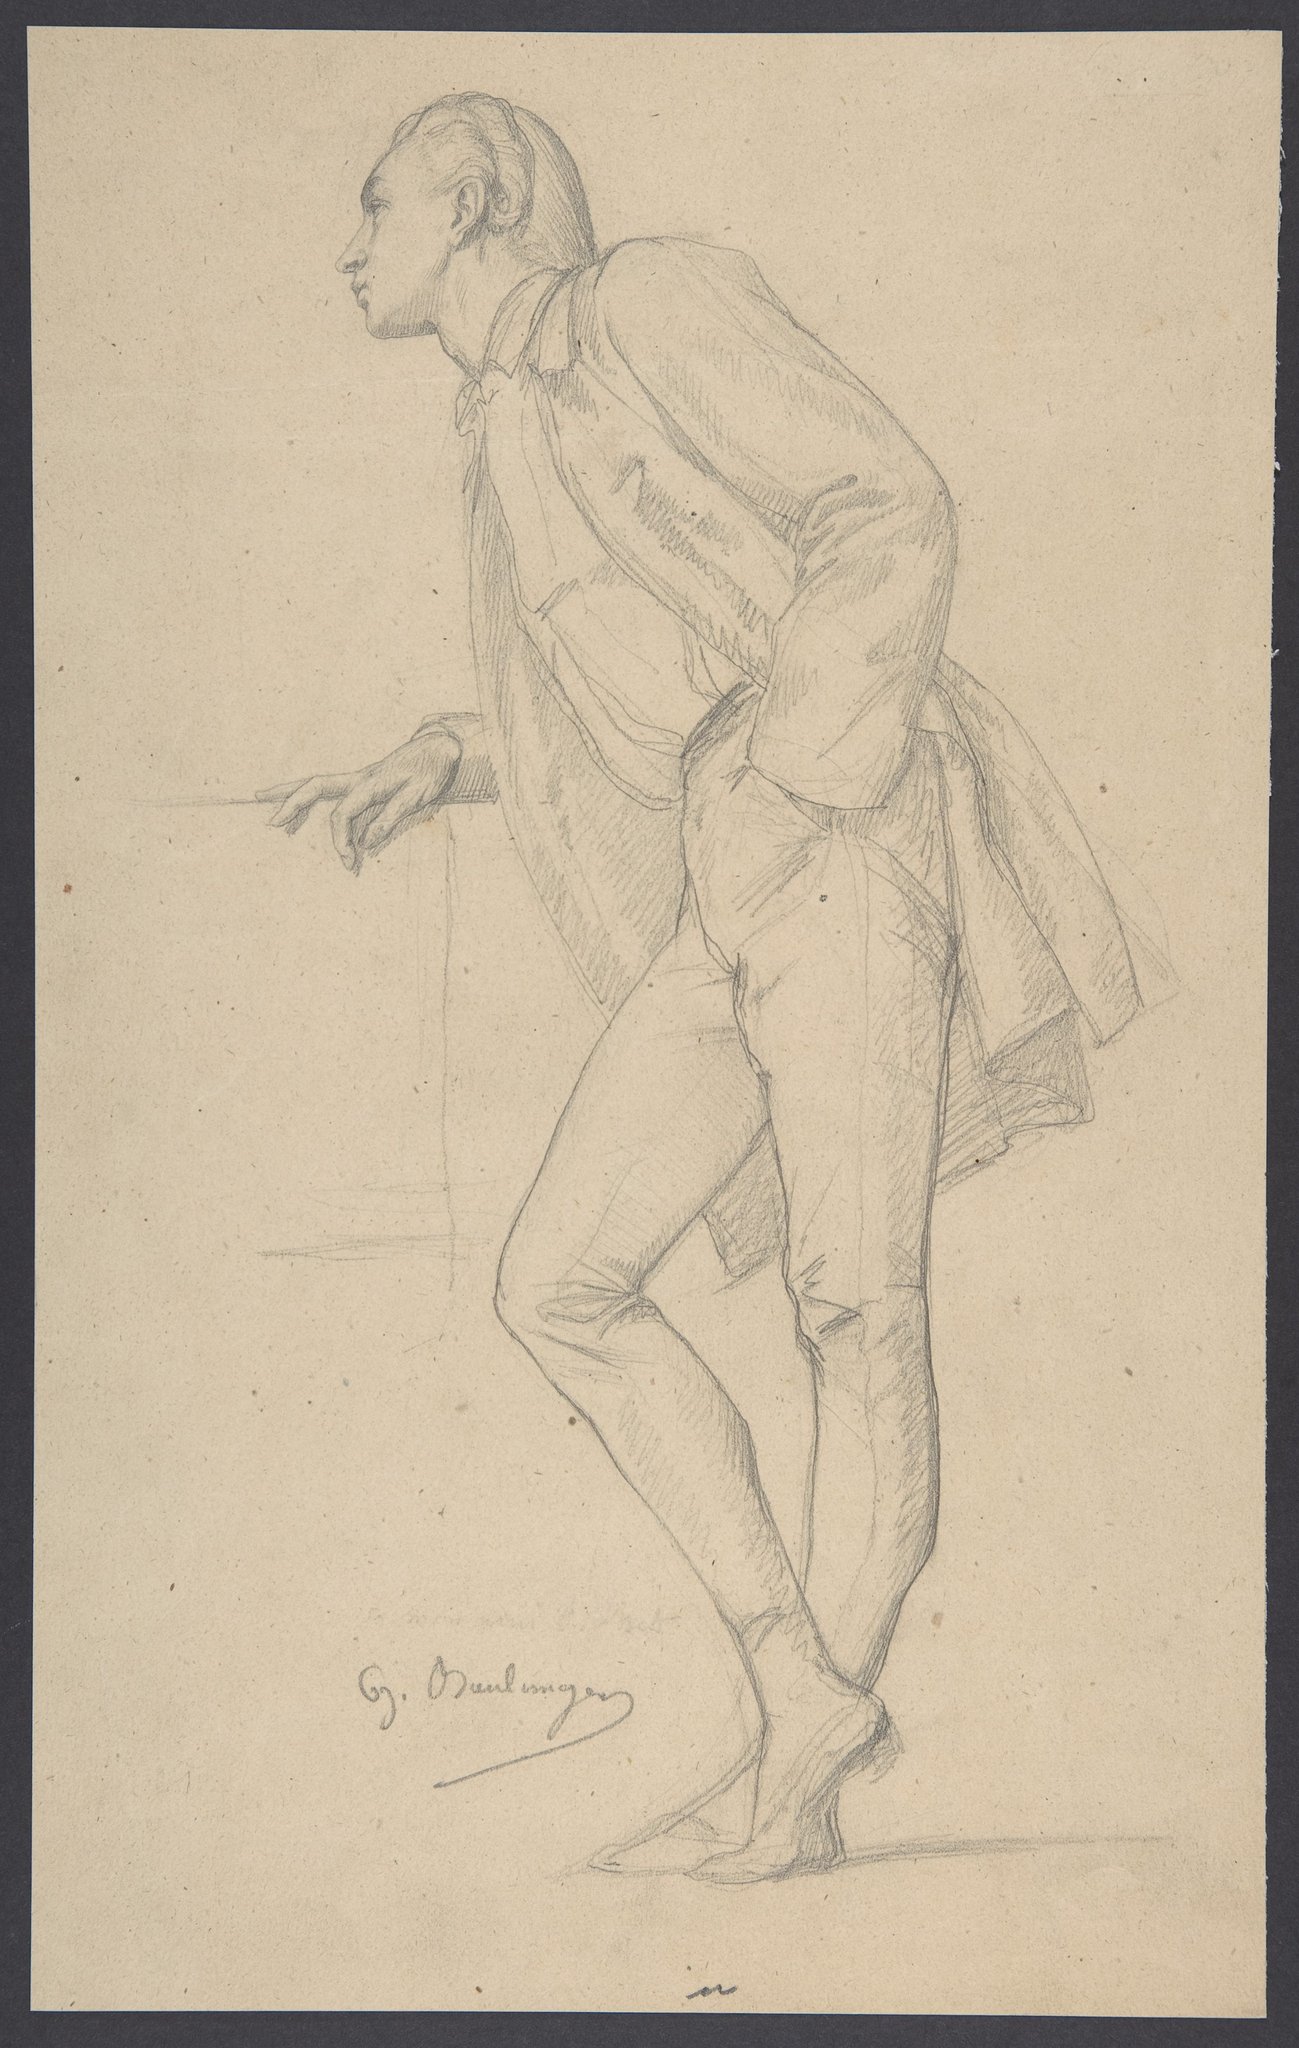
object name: drawing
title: Figure of a Man Standing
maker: anonymous, french, 19th century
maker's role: artist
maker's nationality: french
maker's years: 1800-1900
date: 1801-1900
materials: graphite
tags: men